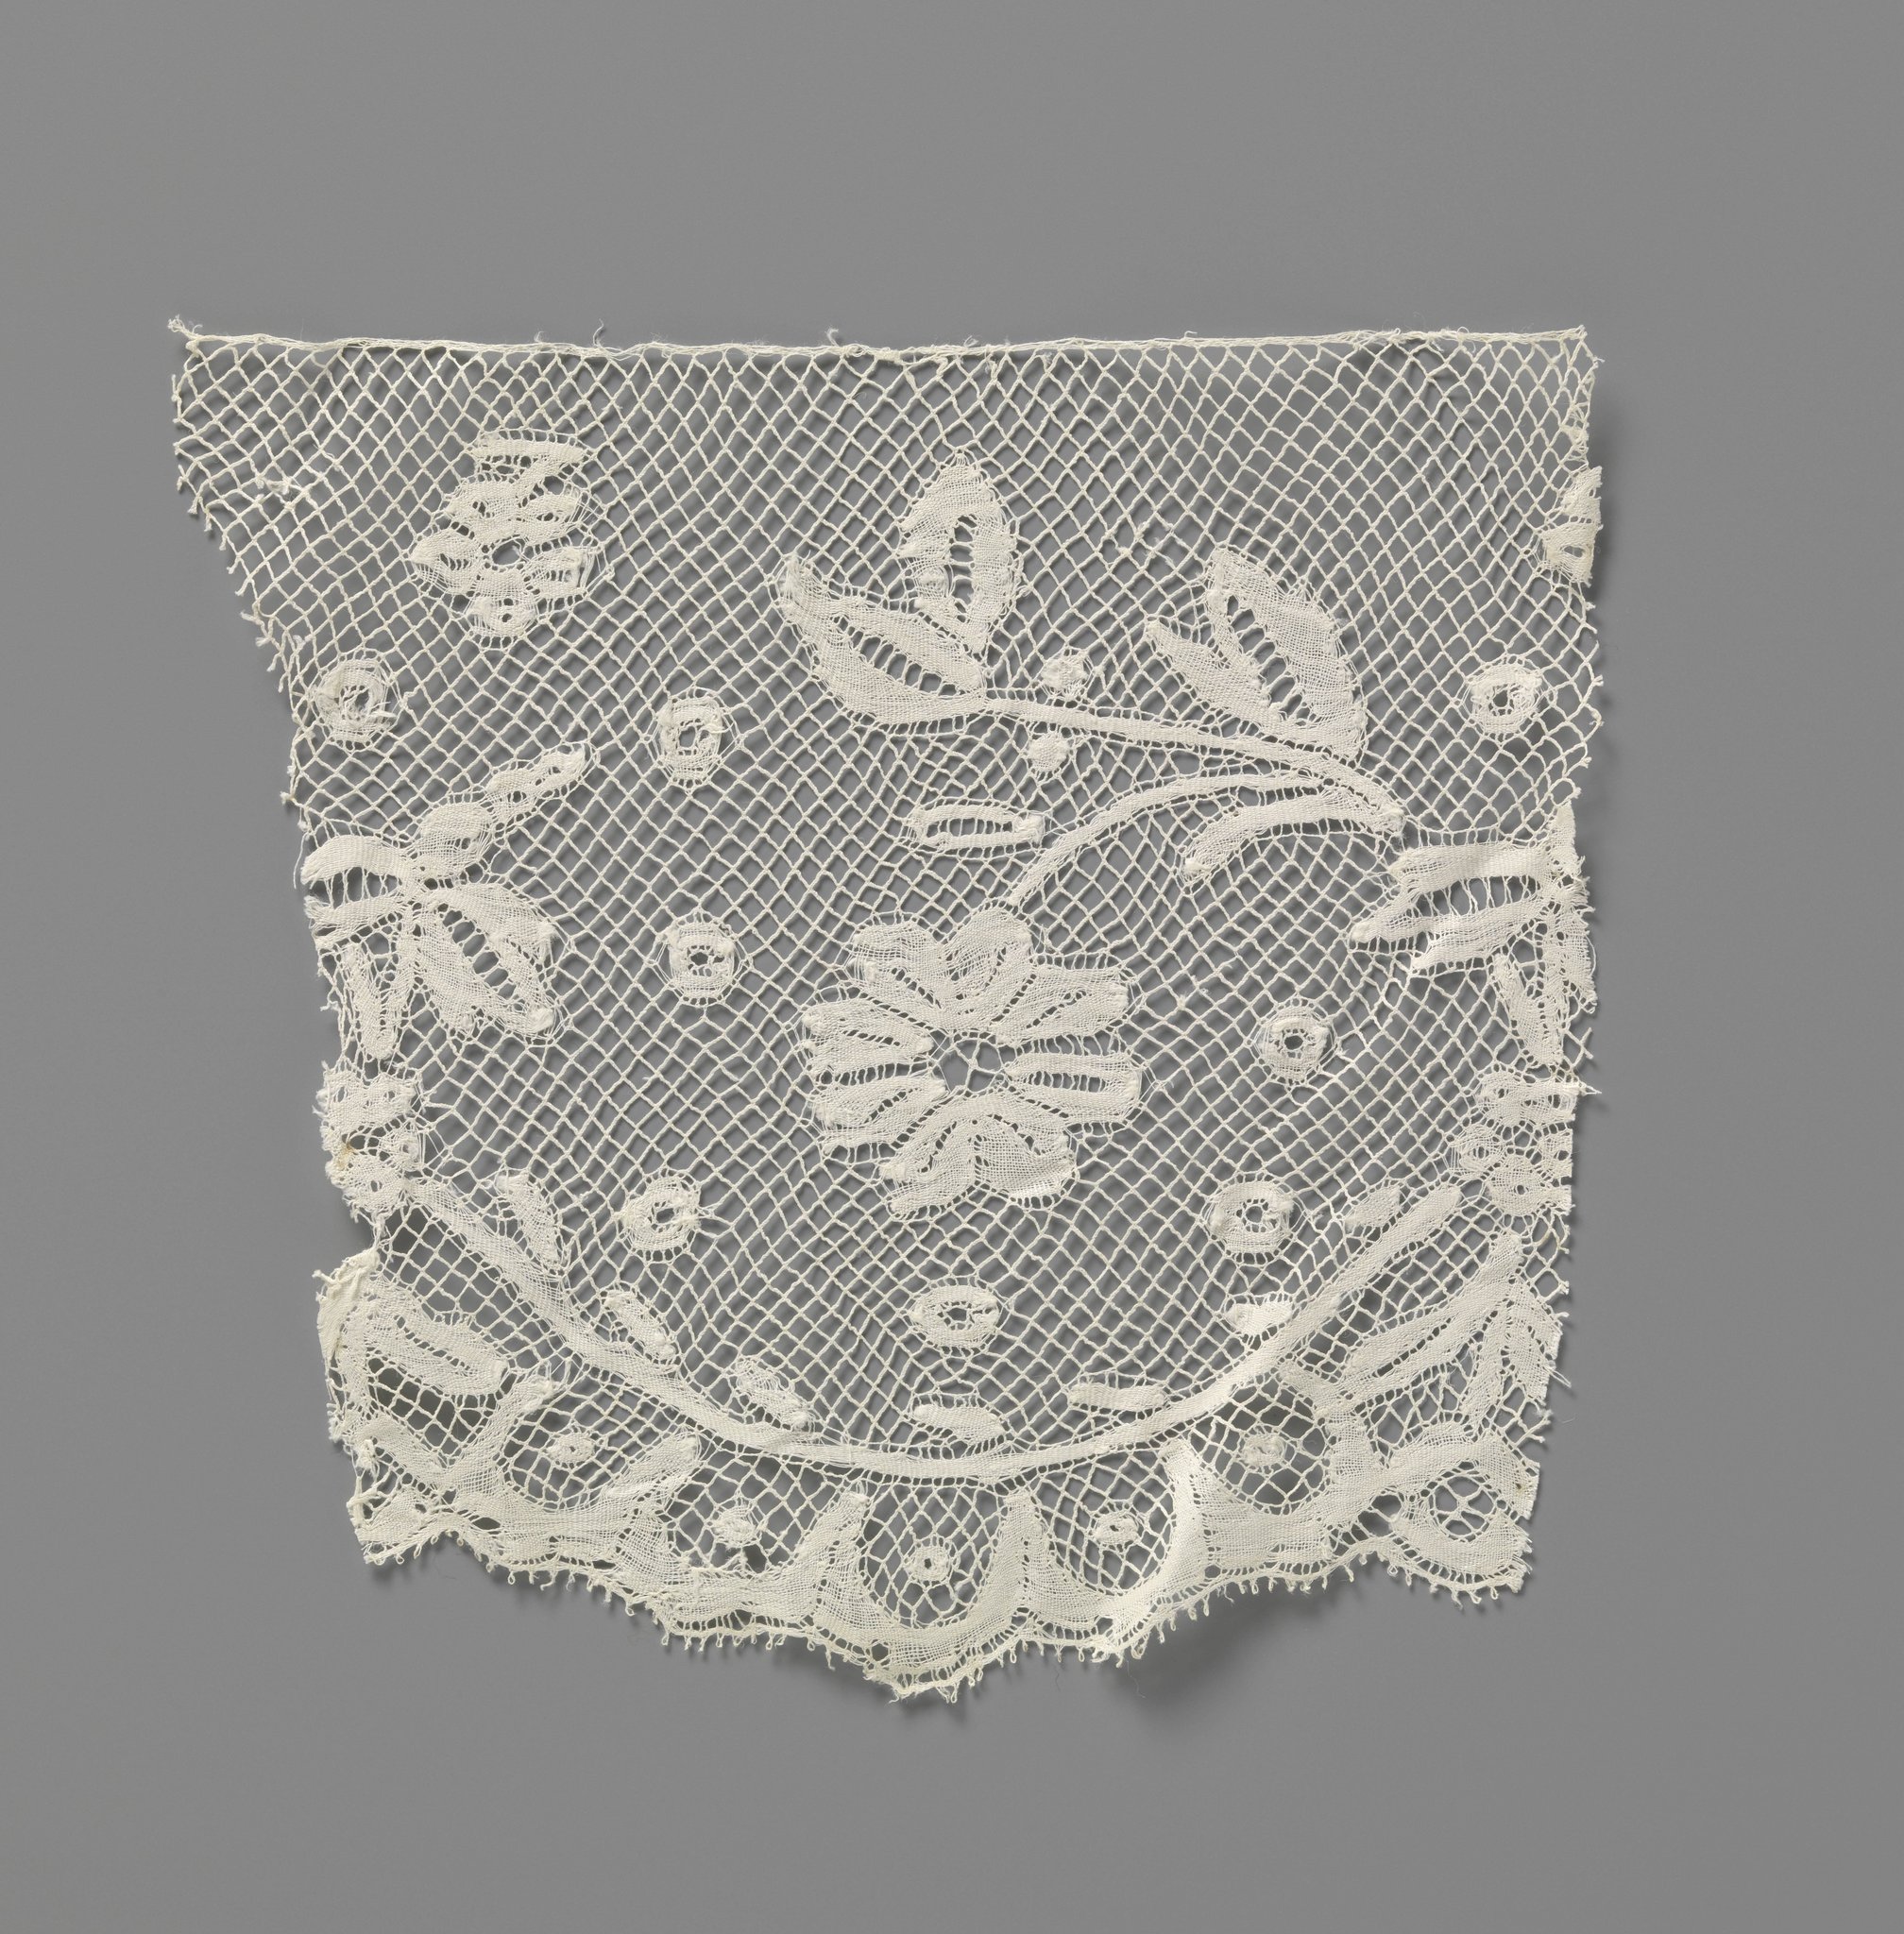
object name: strip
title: Strook kloskant met gegodroneerde schulpen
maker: Anonymous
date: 1875-1899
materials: linen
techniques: lace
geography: sluis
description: Strook naturelkleurige kloskant: Valenciennes-kant. Patroon met gegodronneerde halfcirkelvormige schulpen, waarboven een hangende margriet tussen 'pailletten'.